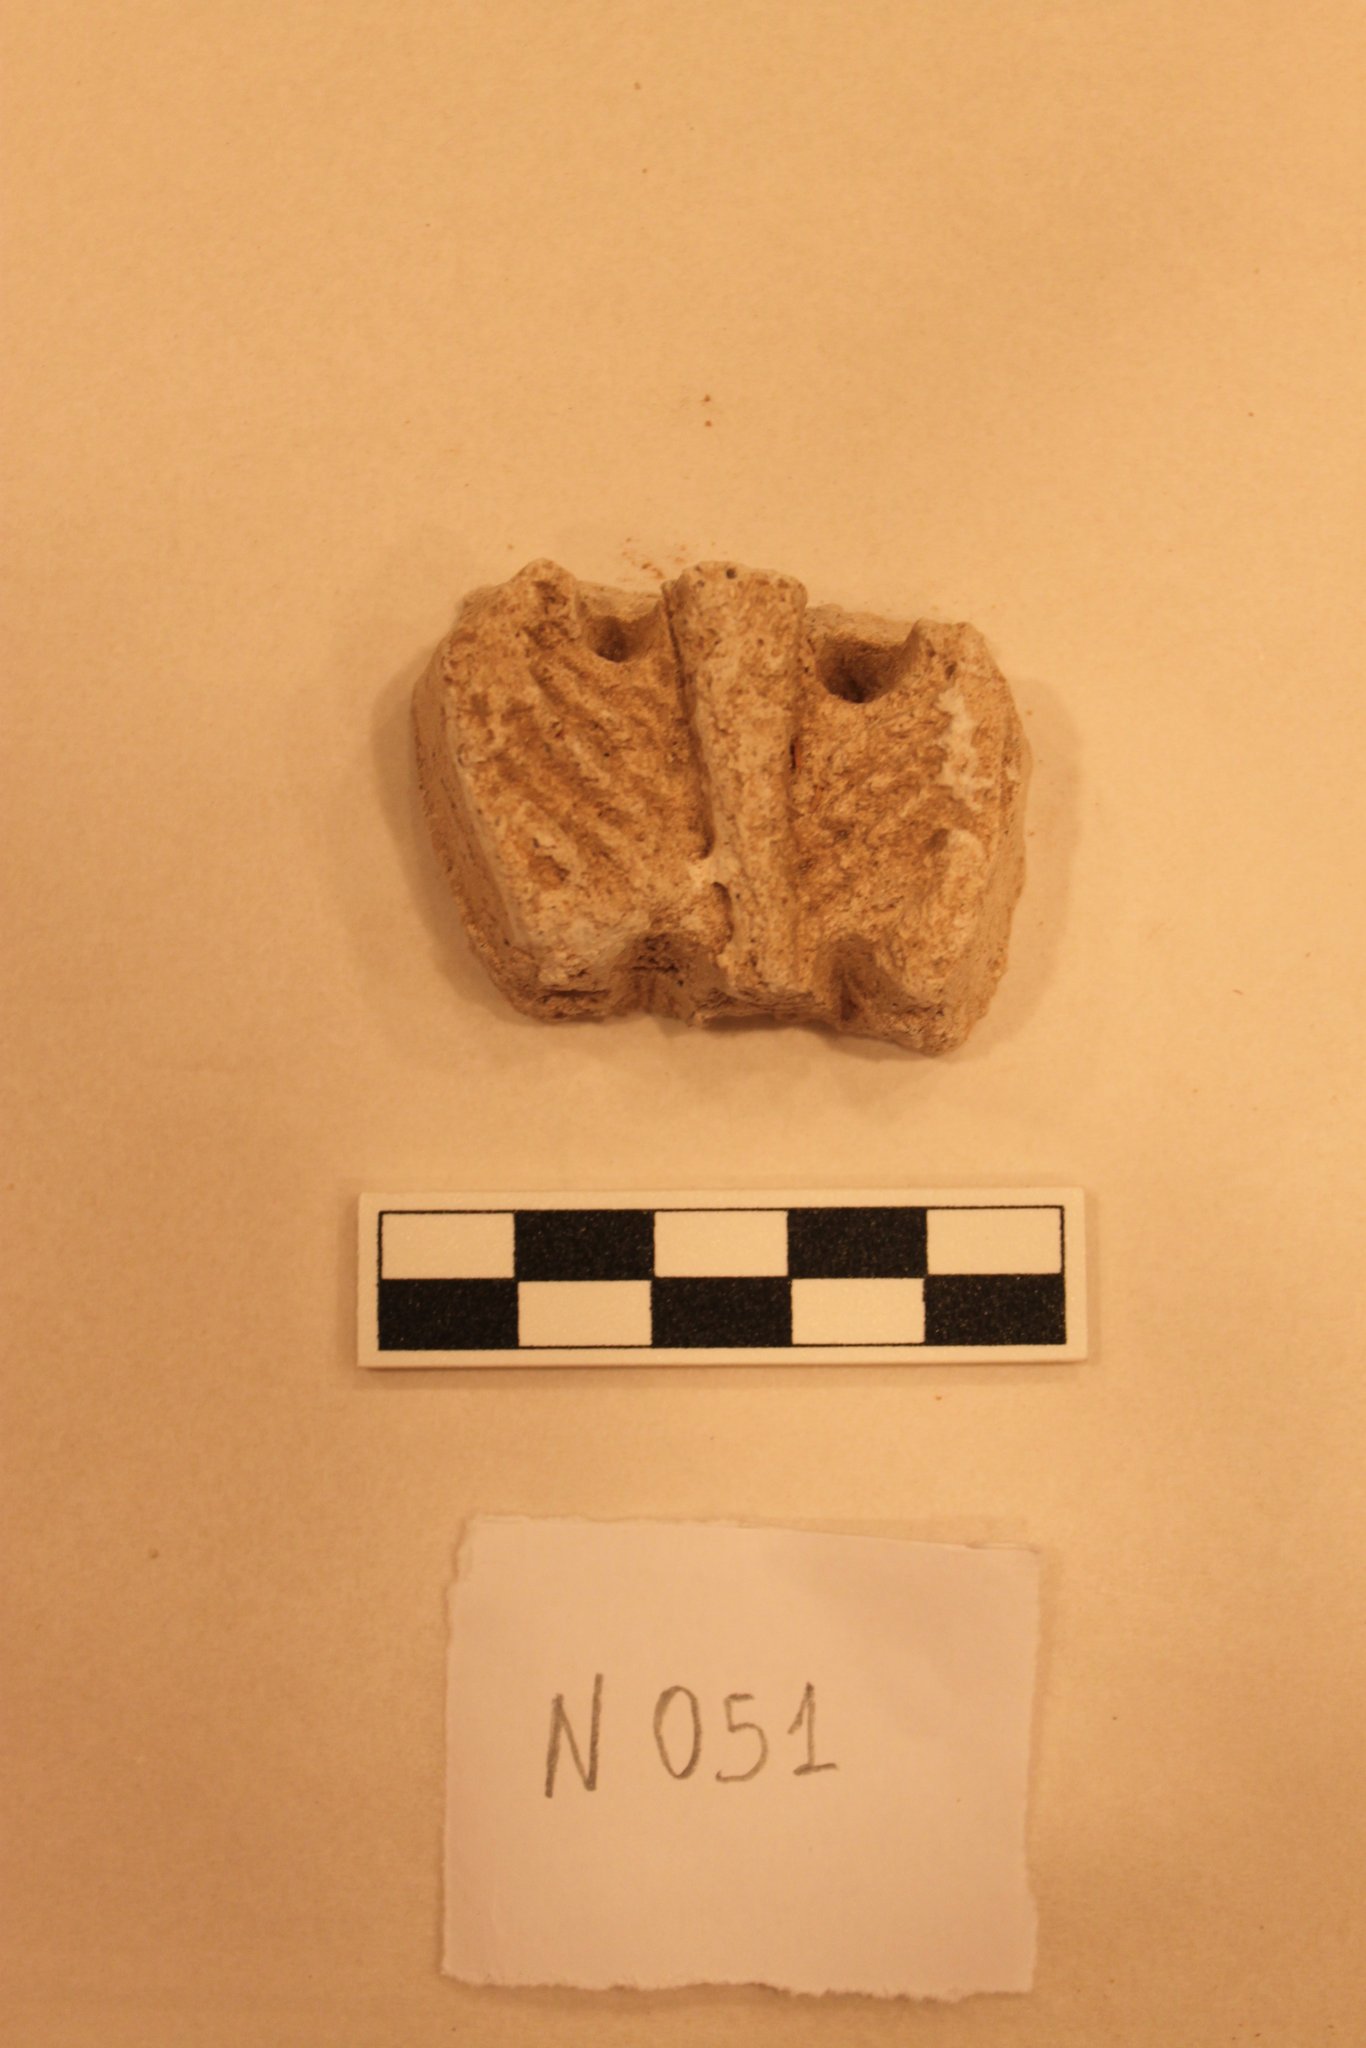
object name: fragment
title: Stucco Fragment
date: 701-1200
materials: plaster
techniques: carving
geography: iran